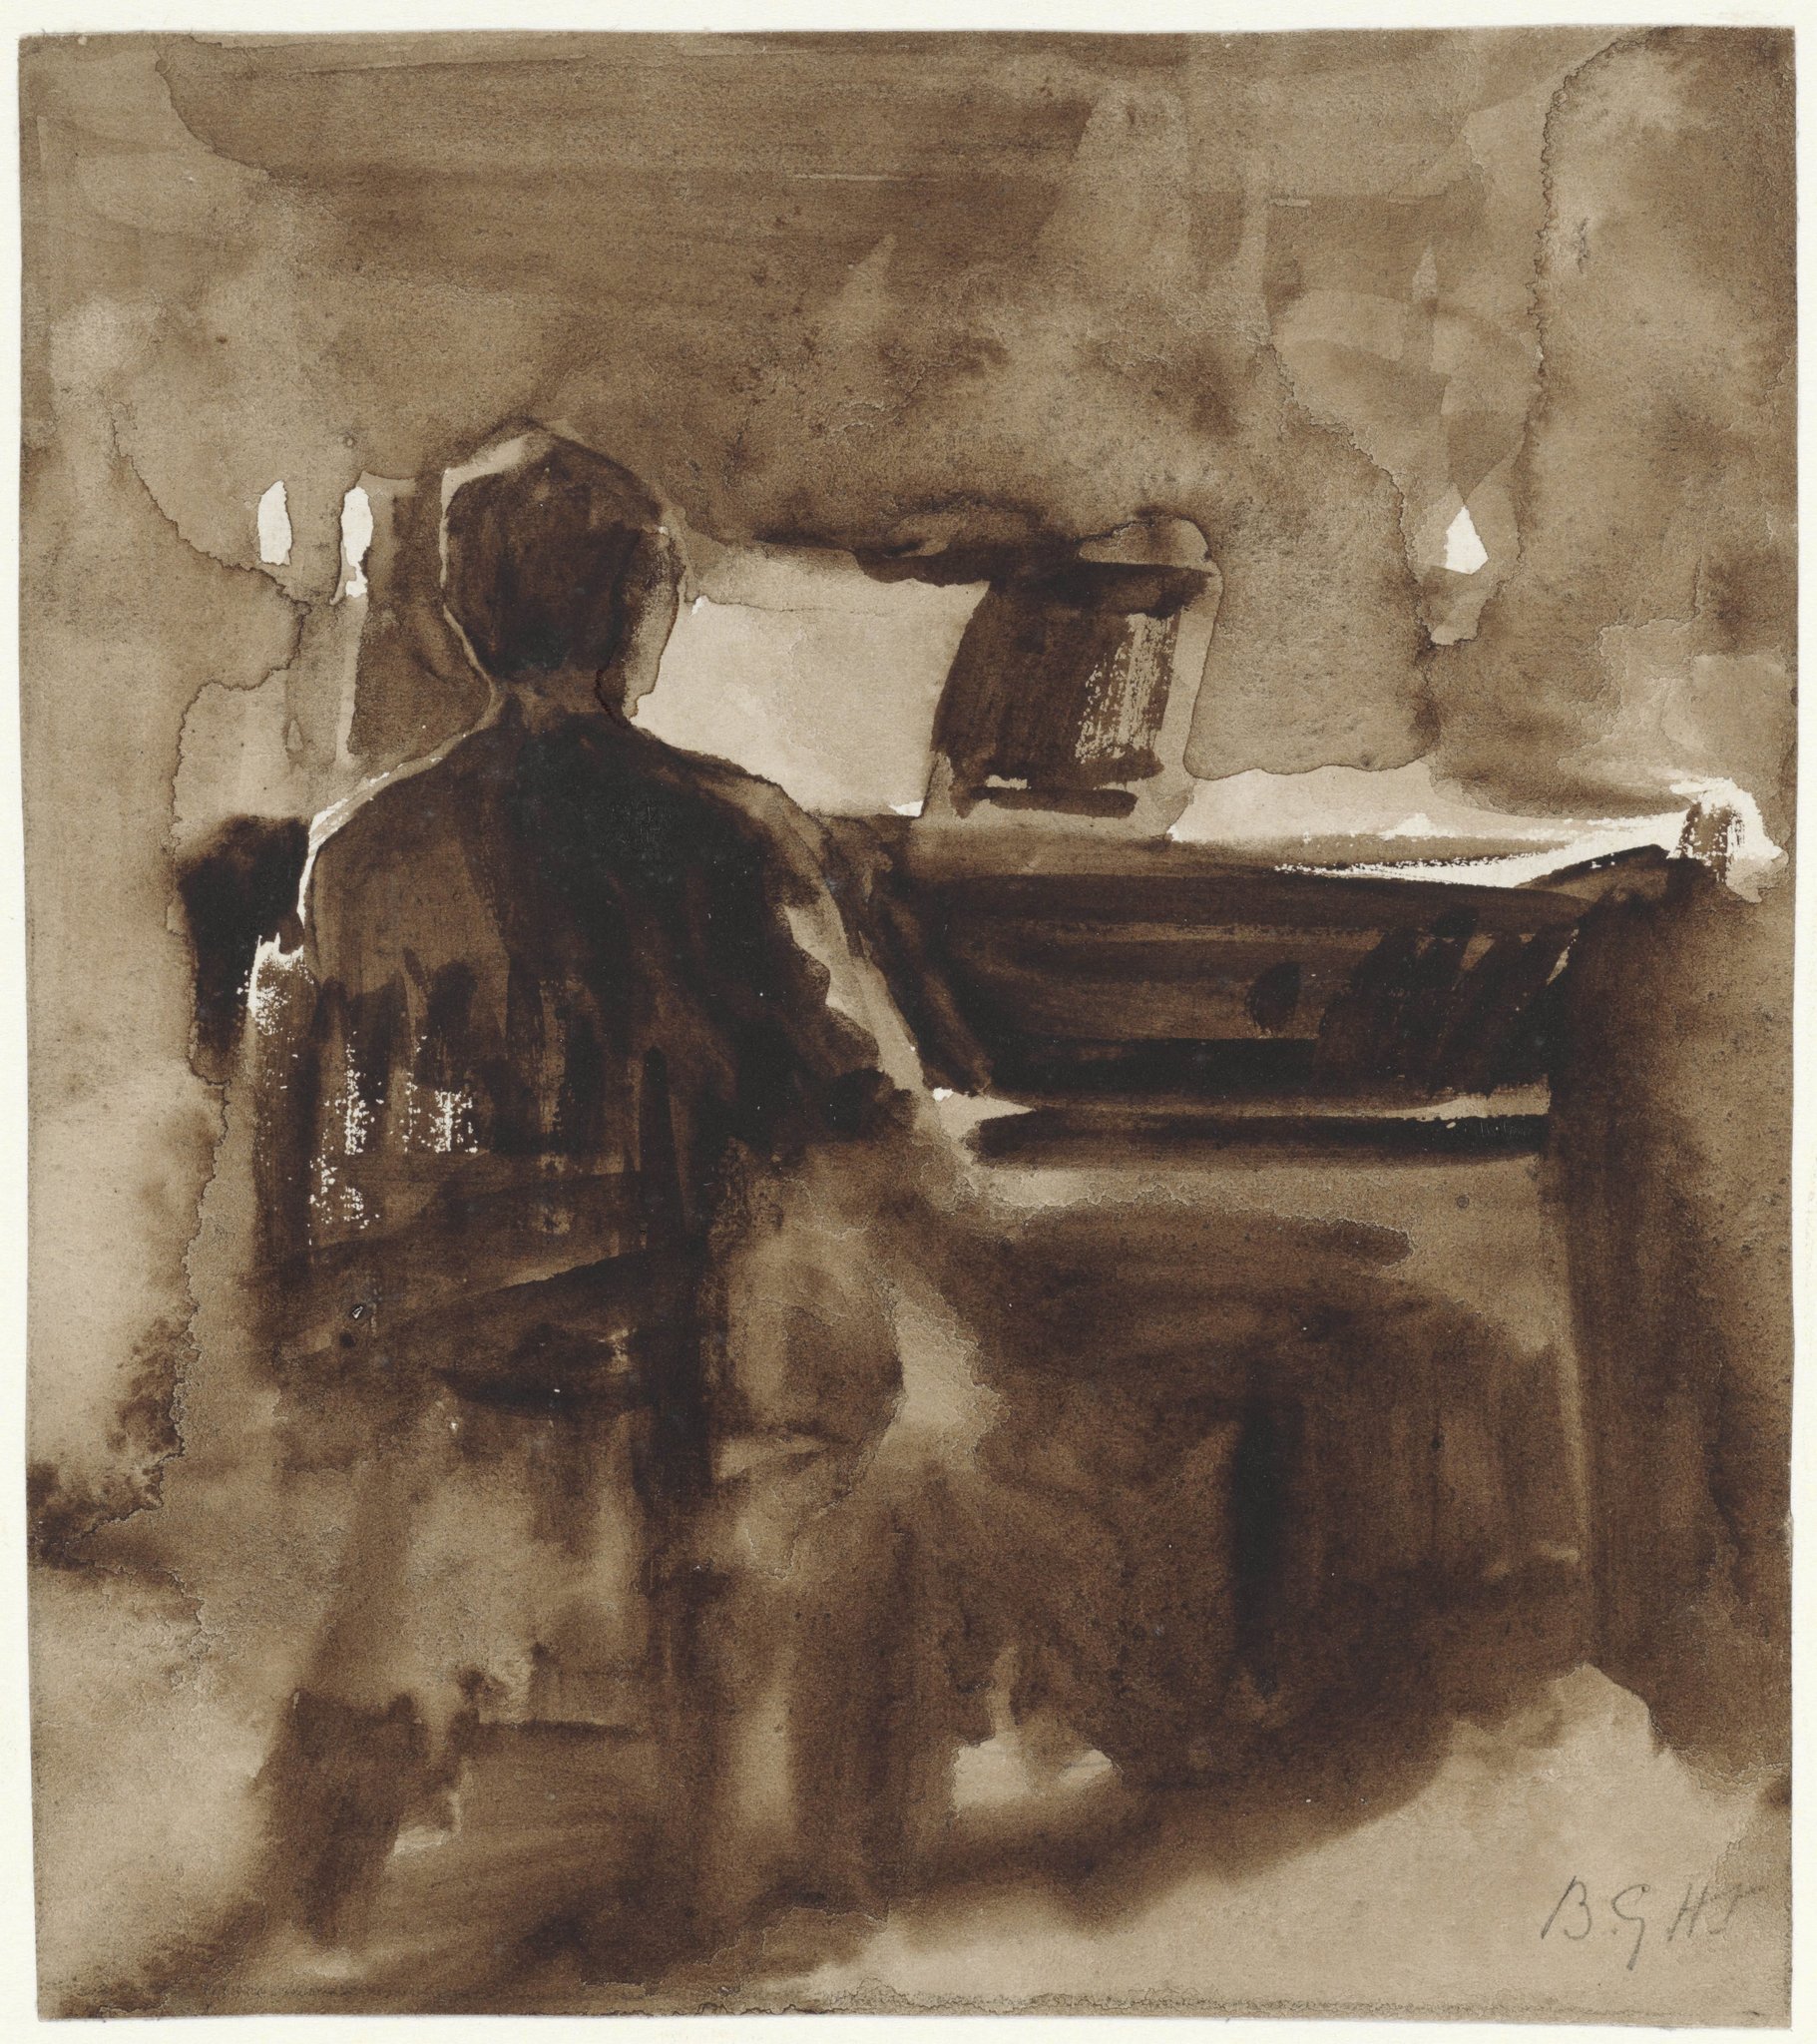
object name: drawing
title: Pianospeler bij kaarslicht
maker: a.a.l. de grammont-hubrecht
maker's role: draughtsman, painter, print maker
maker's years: 1855-1913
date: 1865-1913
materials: paper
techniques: brush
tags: one person playing keyboard instrument, pianoforte